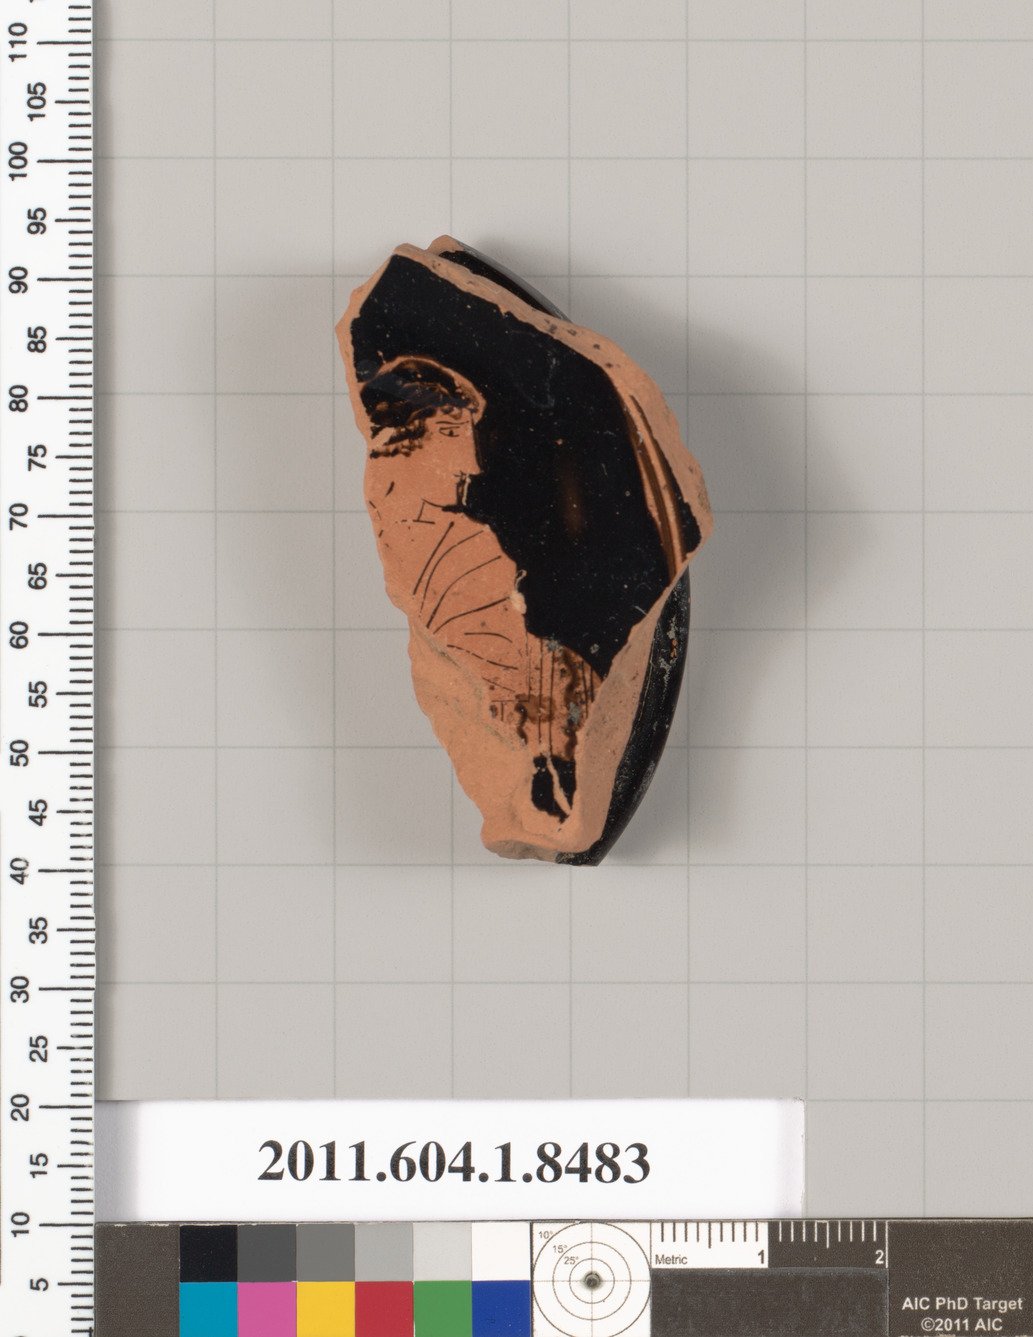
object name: kylix fragment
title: Terracotta fragment of a stemless kylix (drinking cup)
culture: greek, attic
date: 460-450 BCE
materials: terracotta